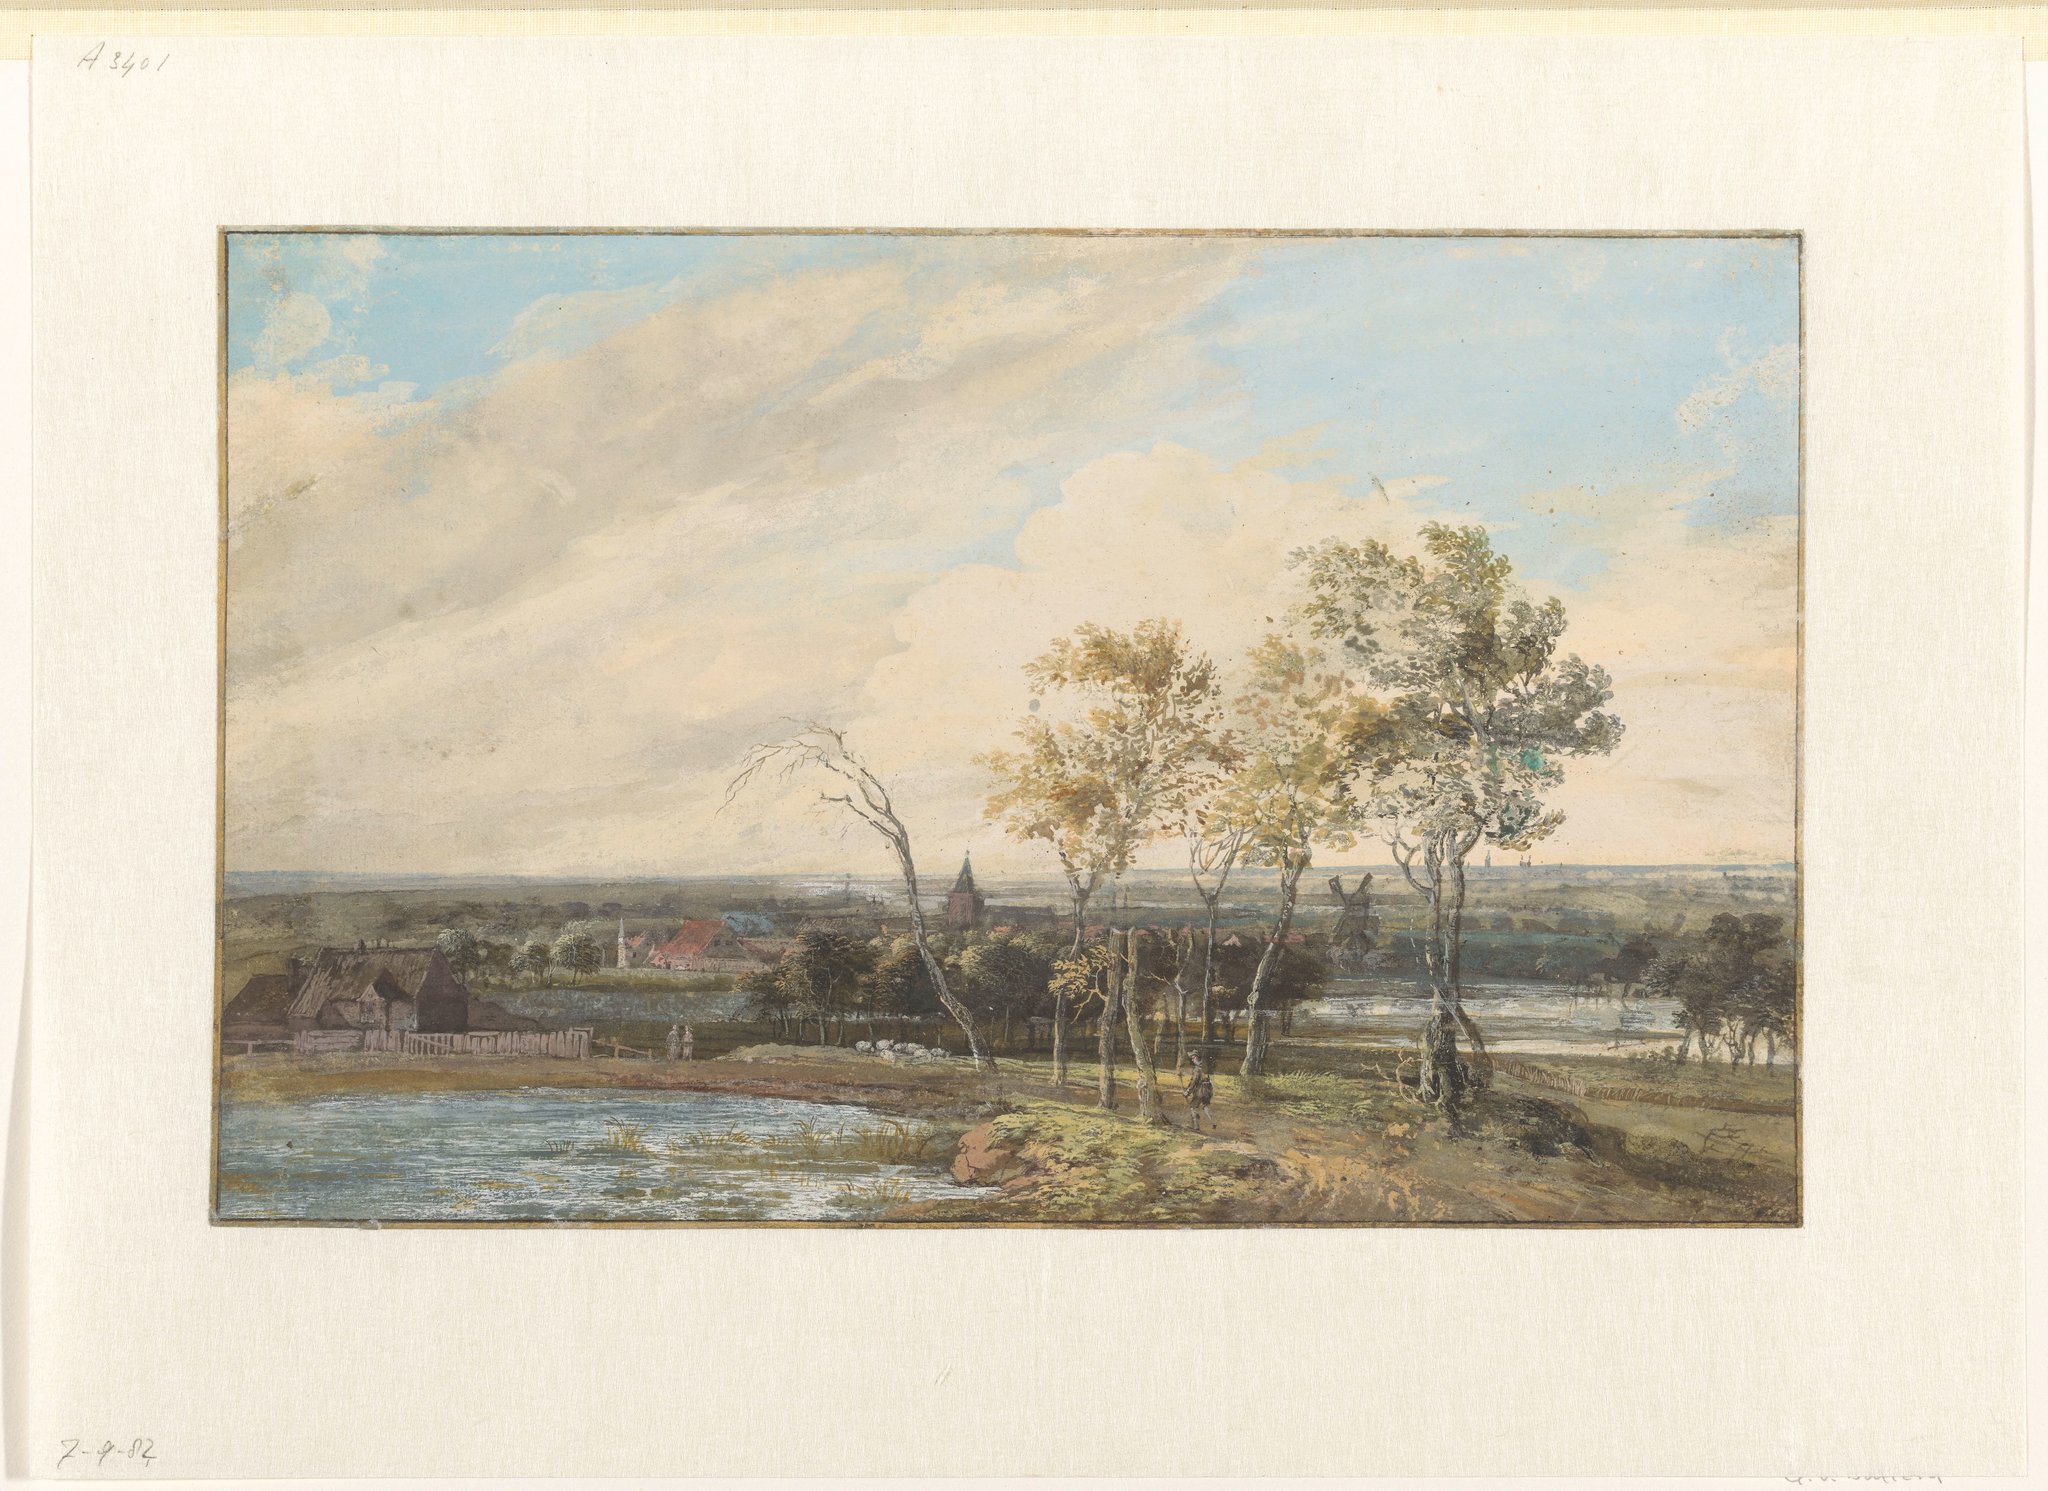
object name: drawing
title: Rivierlandschap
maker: gerrit battem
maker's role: draughtsman, painter, print maker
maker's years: 1636-1684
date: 1646-1684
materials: paint, gouache, paper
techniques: brush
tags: river (+ landscape with figures, staffage)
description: Panorama over een bebouwde vlakte. Op de voorgrond een weg tussen bomen aan een vijver voorbijvoerend.